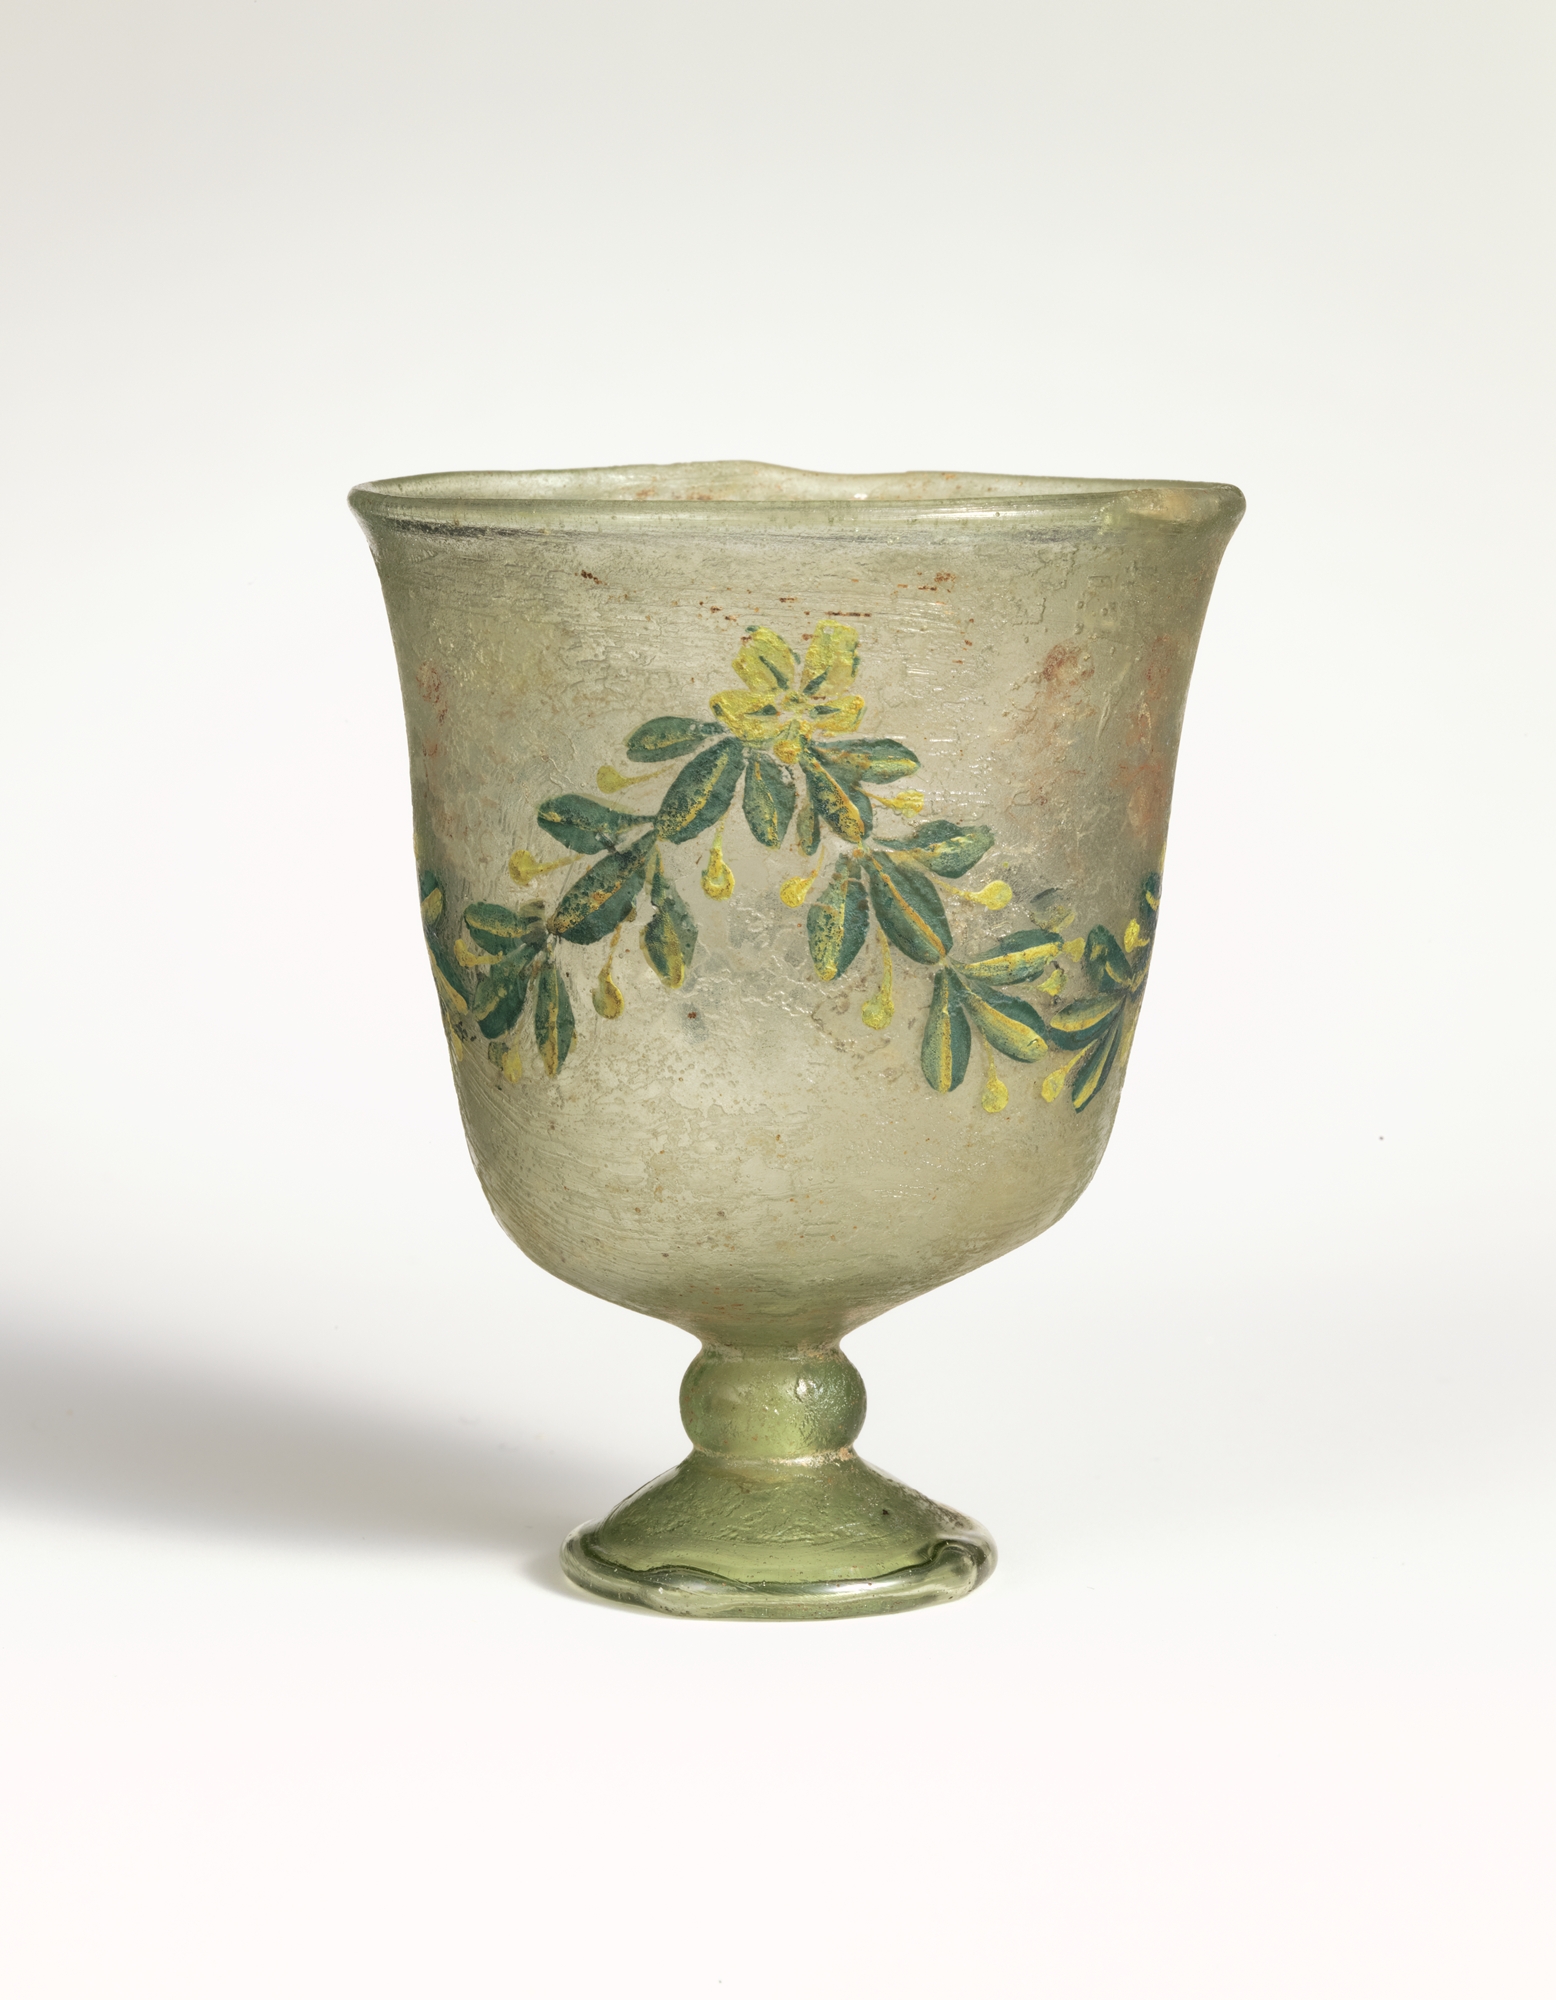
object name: goblet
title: Glass goblet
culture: roman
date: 301-400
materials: glass